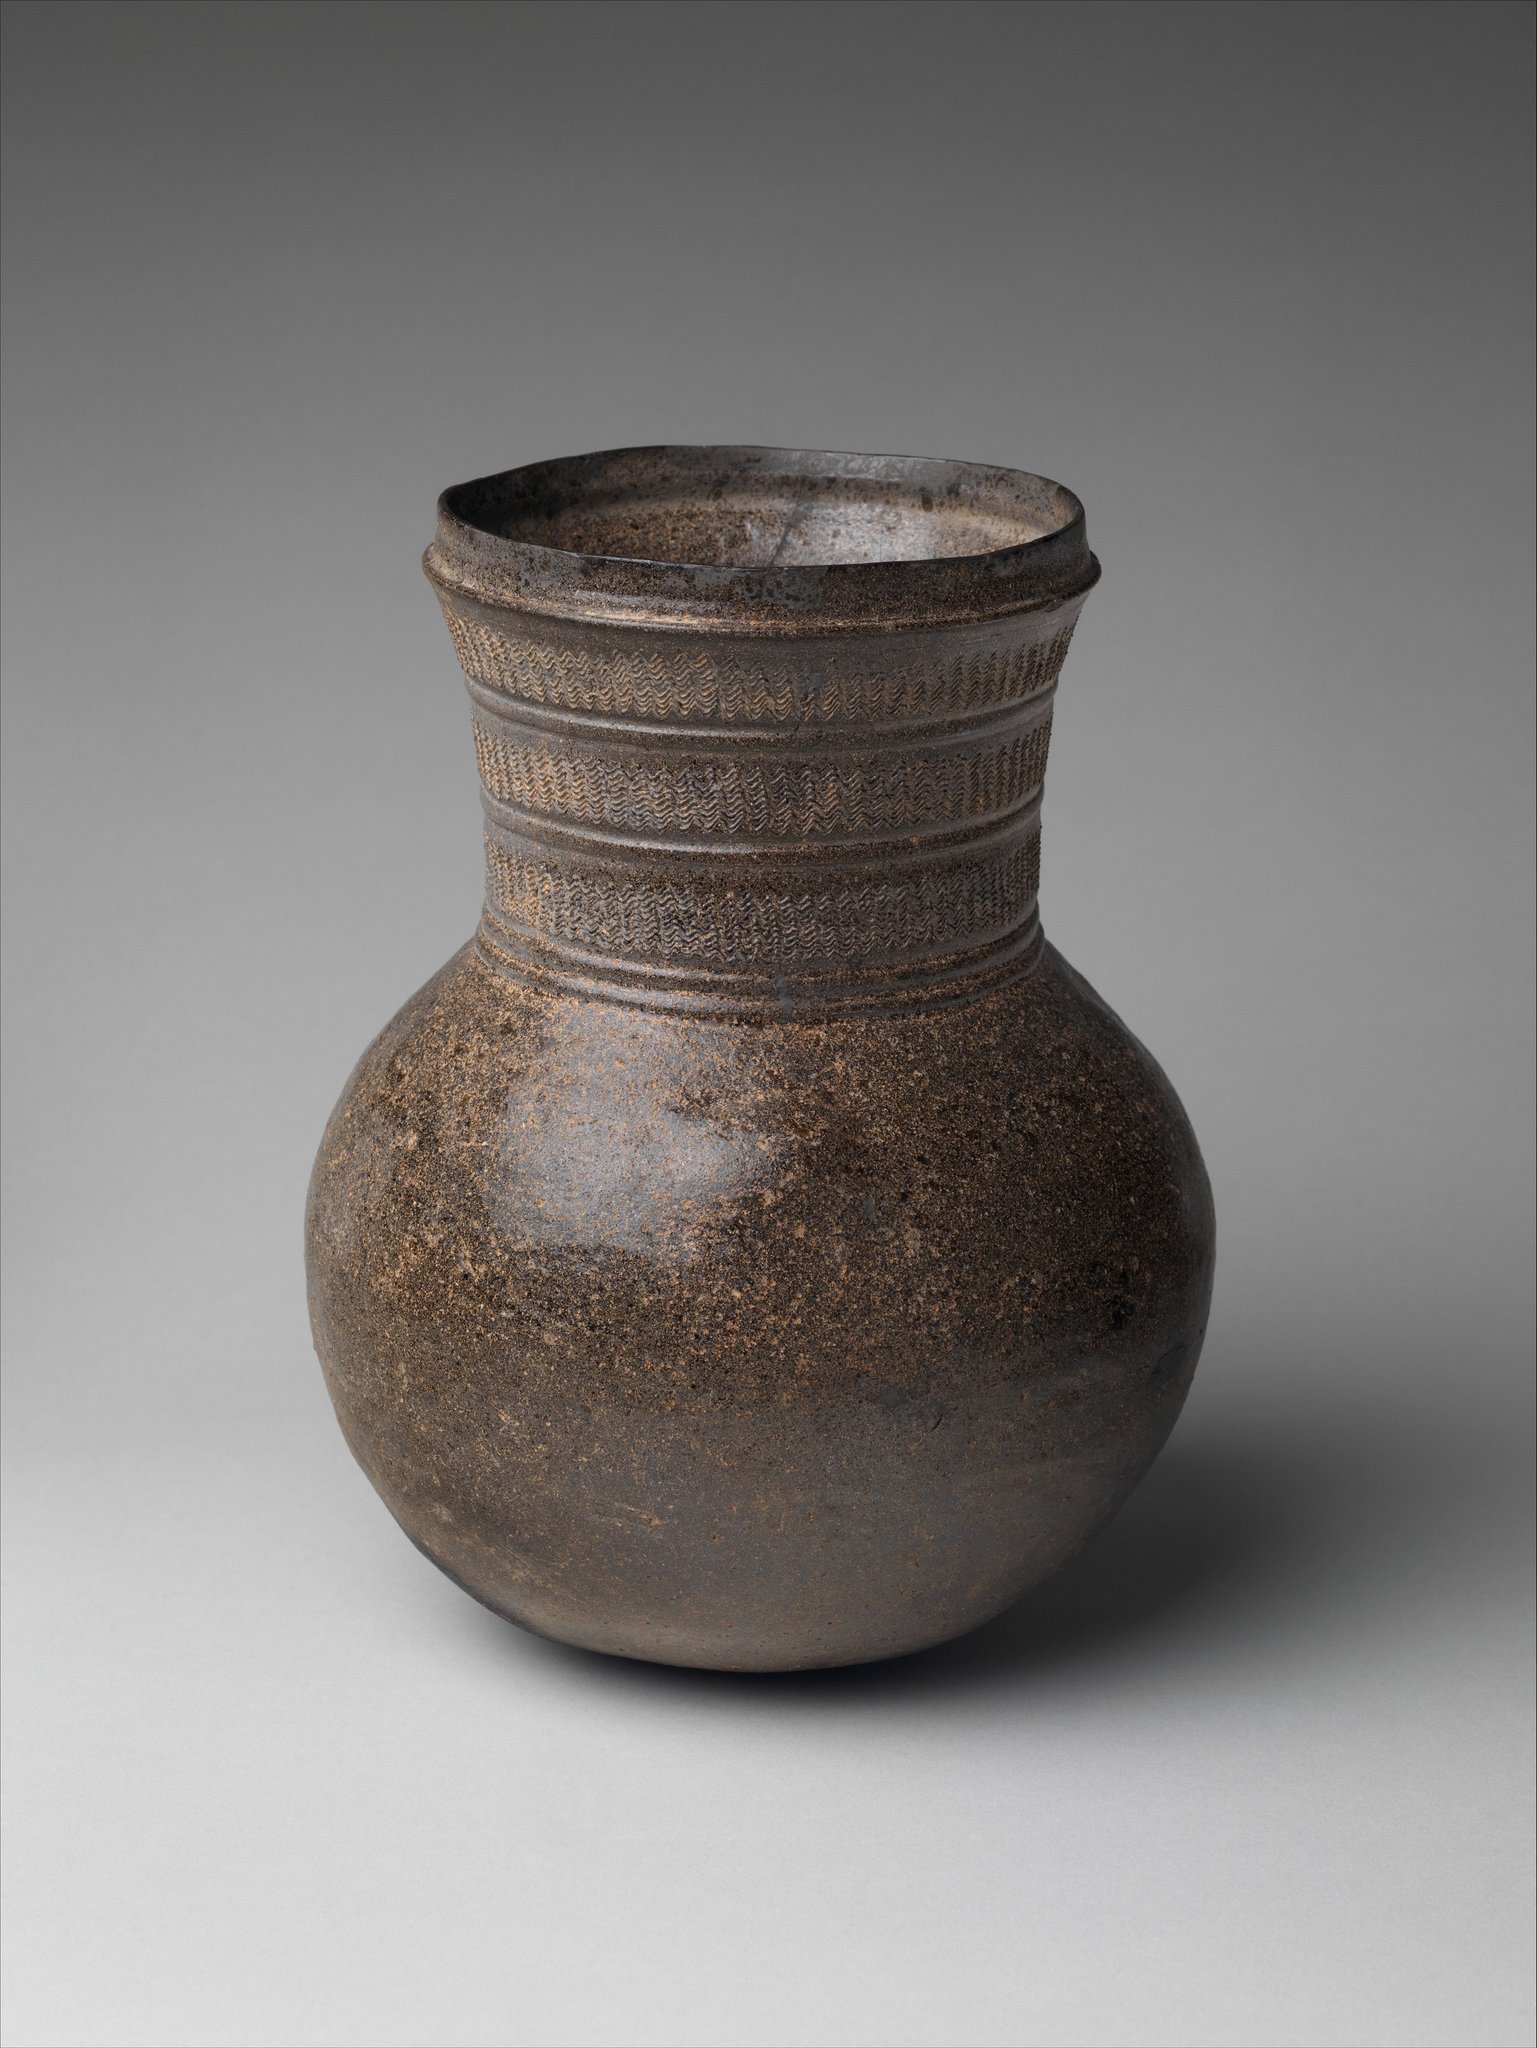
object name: jar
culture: korean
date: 451-475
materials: wood, glaze, stoneware